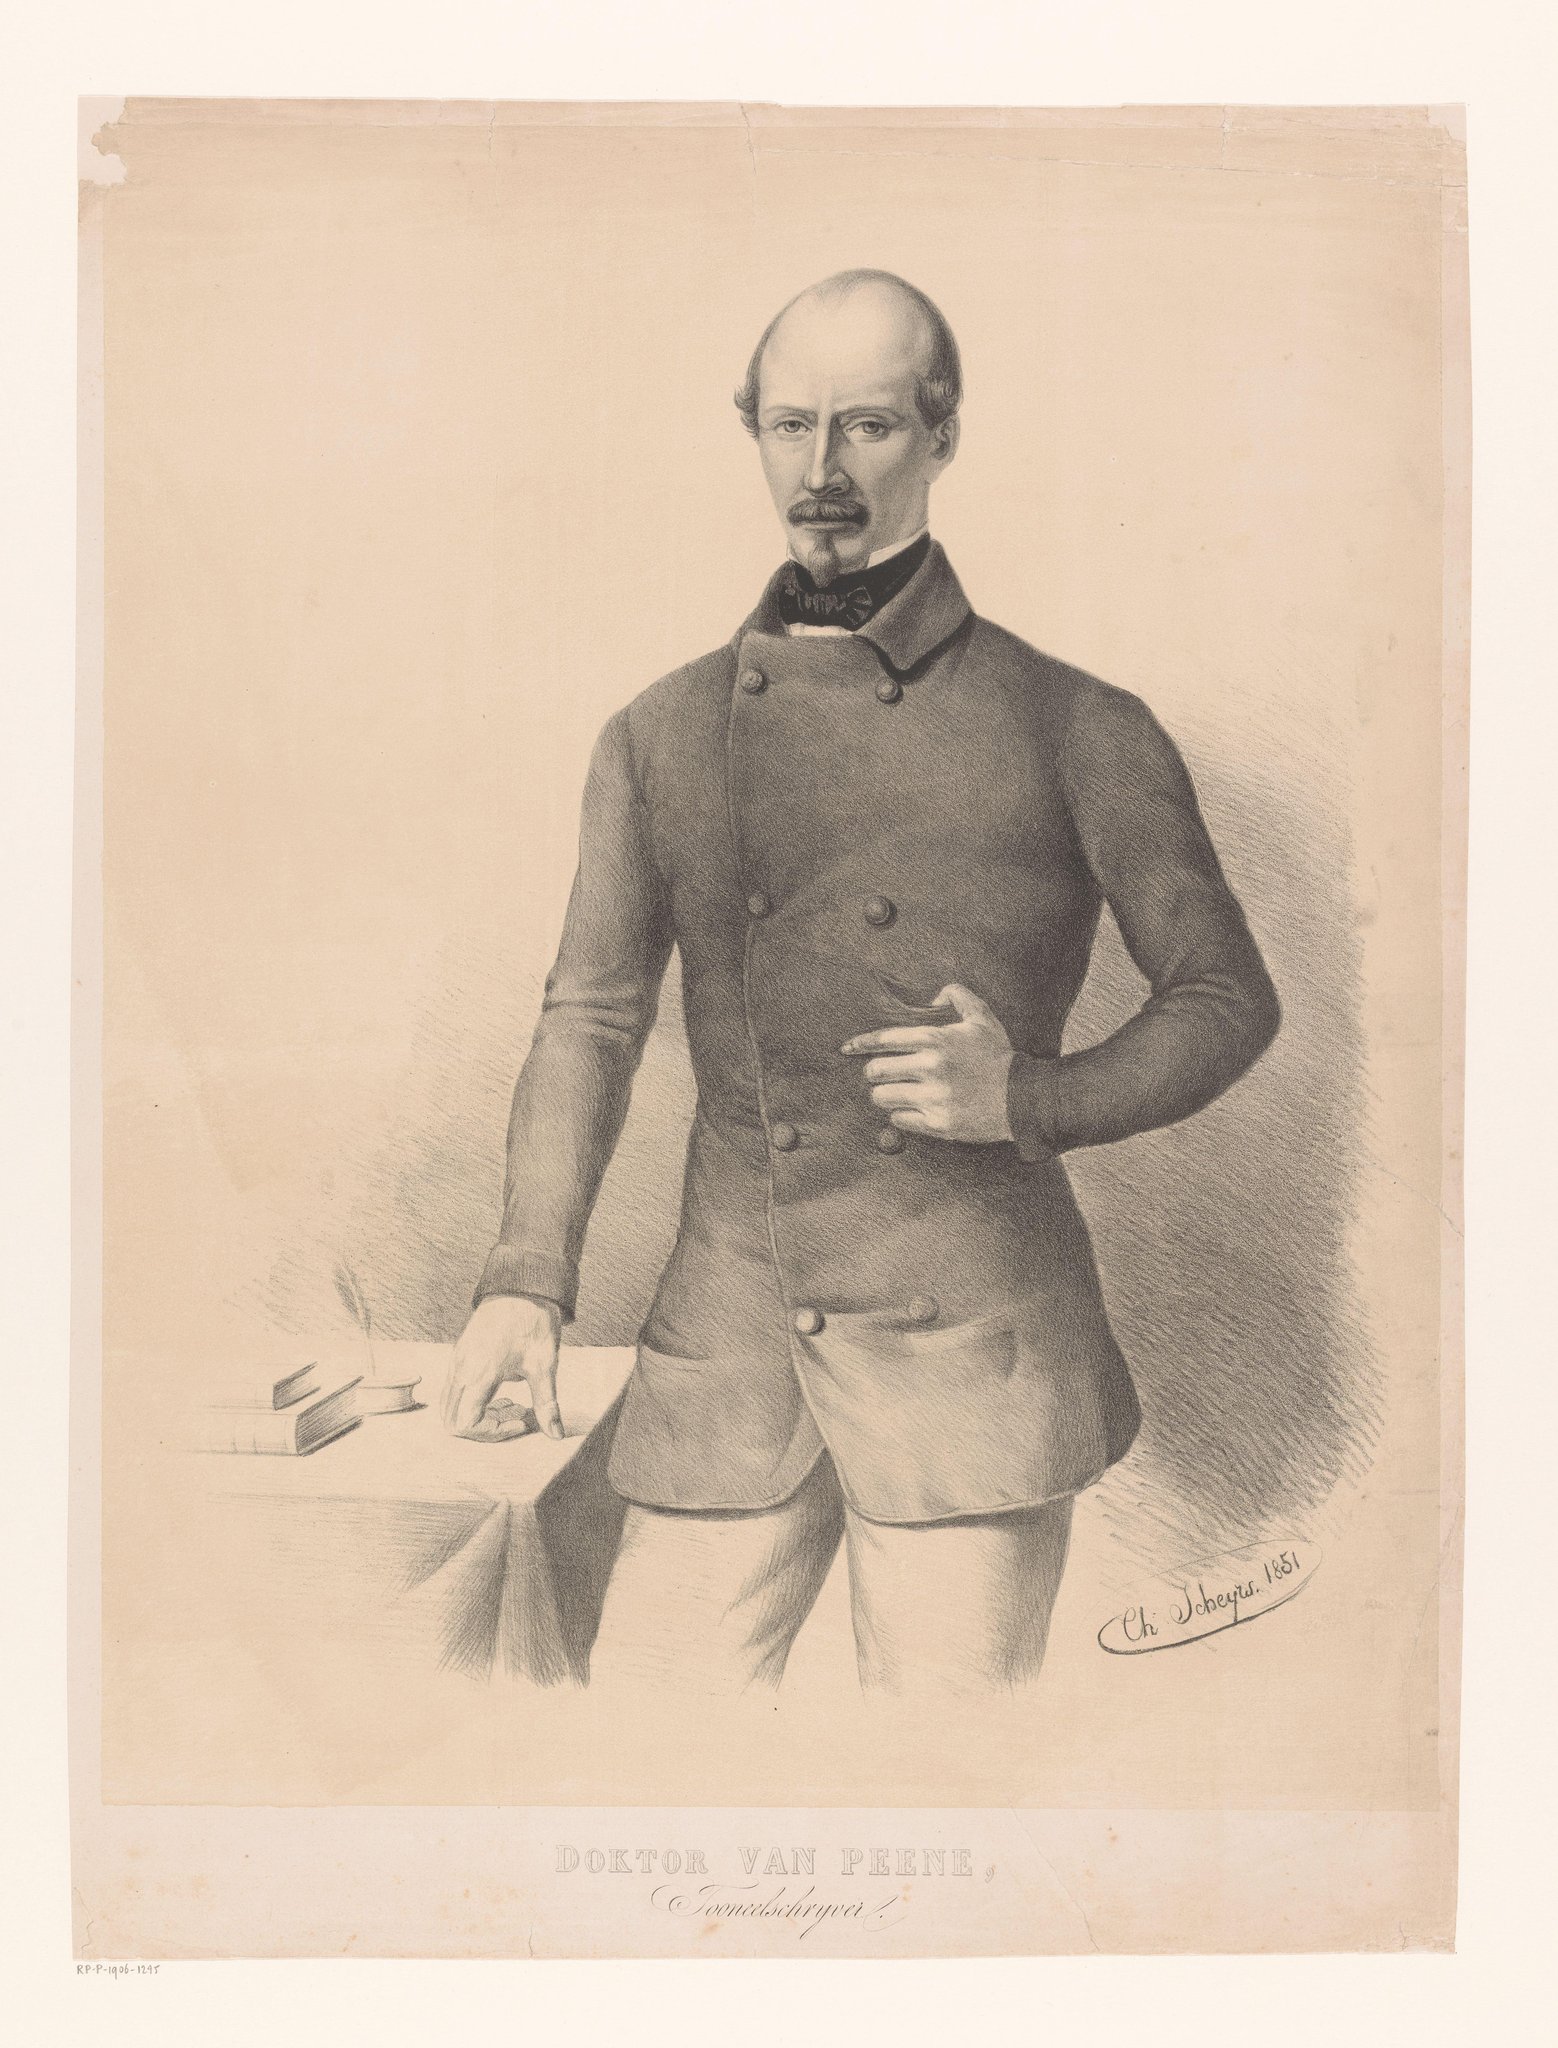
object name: print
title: Doktor van Peene, Tooneelschryver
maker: ch. scheyrs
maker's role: print maker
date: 1851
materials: paper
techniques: lithograph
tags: moustache, adult man, historical persons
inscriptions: collector's mark: Lugt 2228